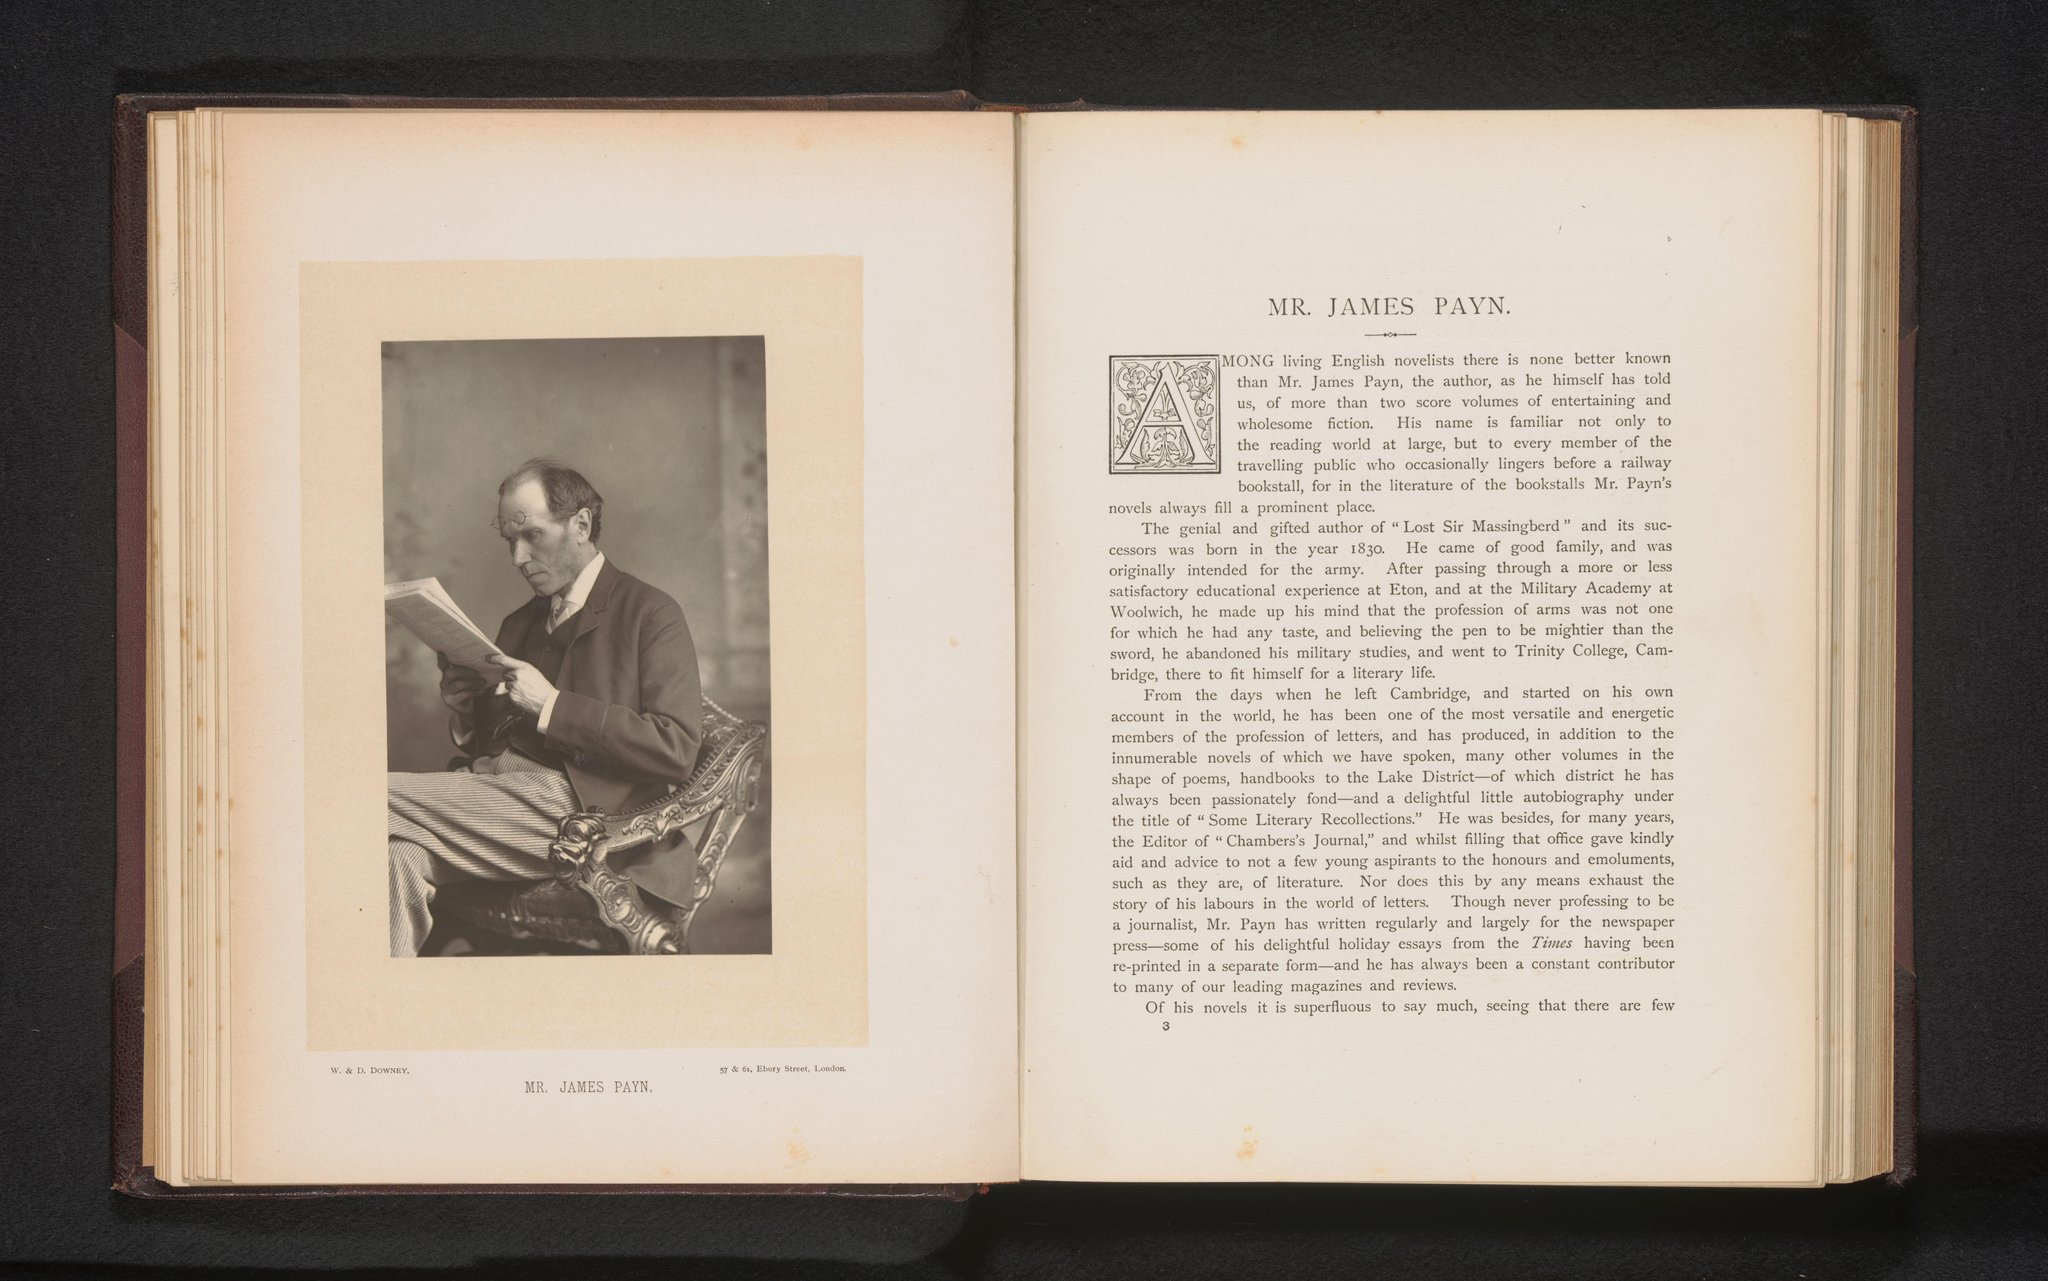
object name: photograph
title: Portret van James Payn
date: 1885-1890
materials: paper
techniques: carbon print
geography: london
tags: james payn, historical persons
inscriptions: address: ‘57 & 61, Ebury Street, London.’